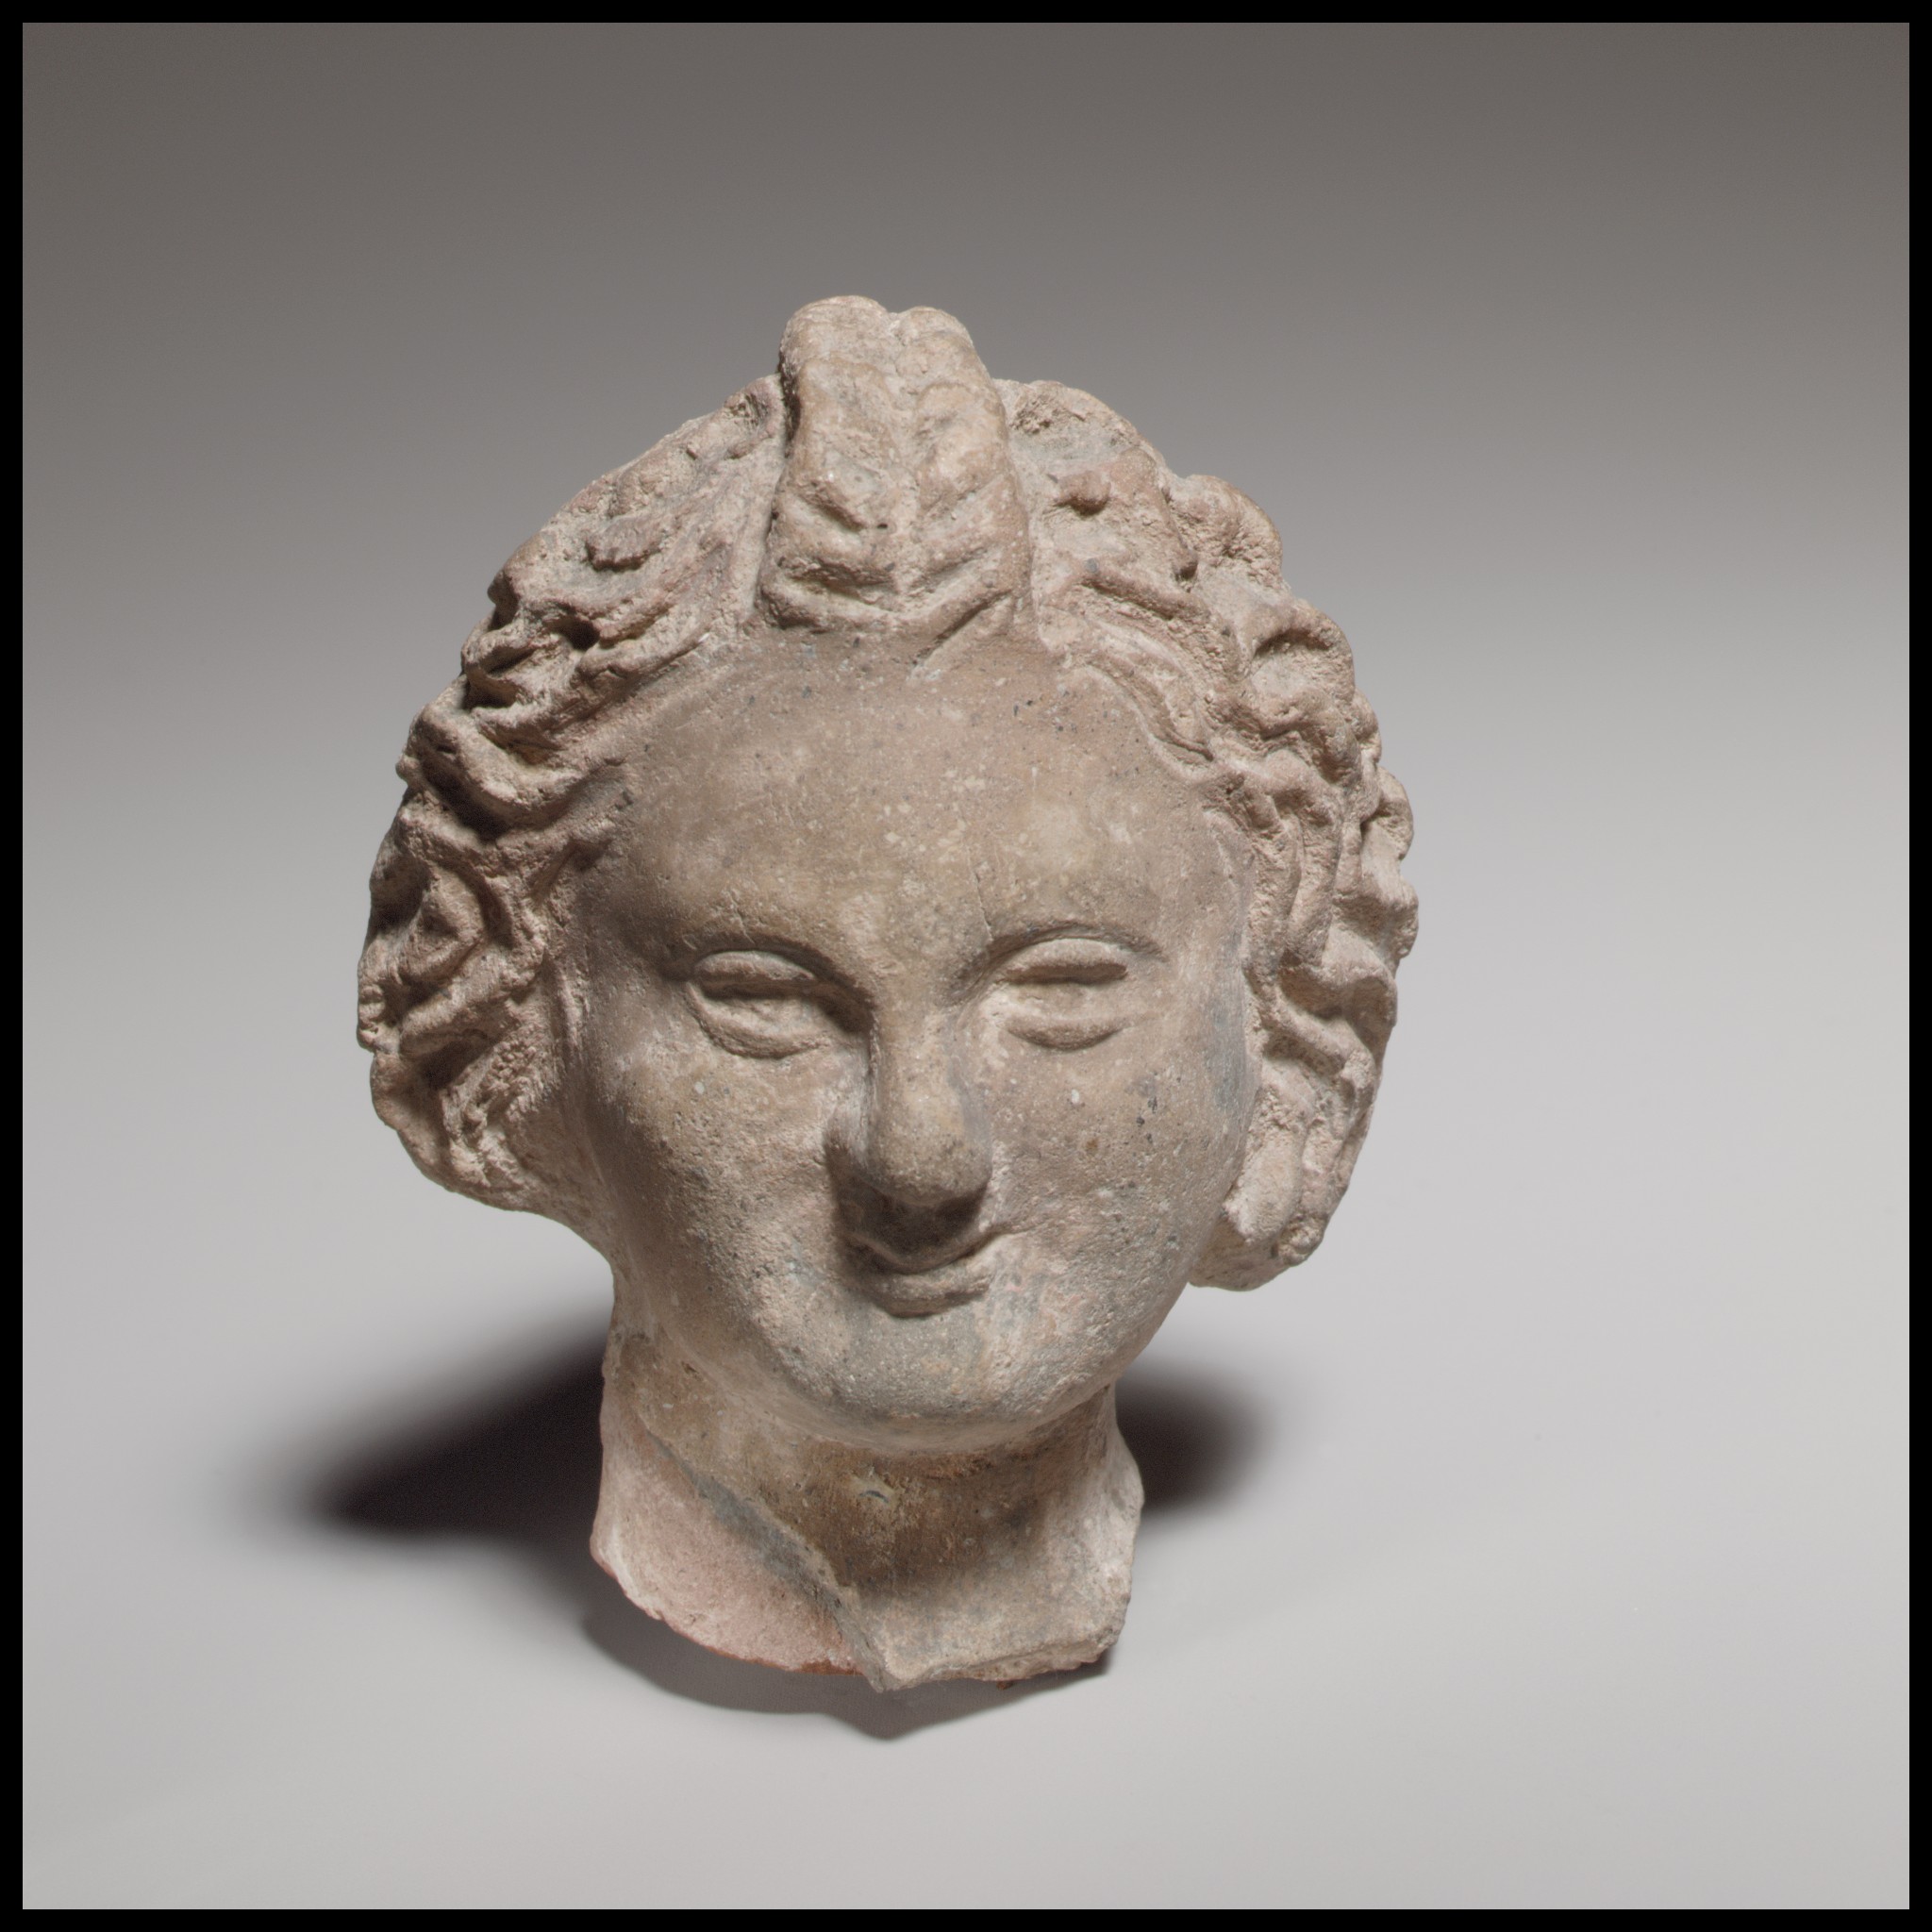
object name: head of eros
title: Head of a child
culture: cypriot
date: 200-101 BCE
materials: terracotta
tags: heads,children